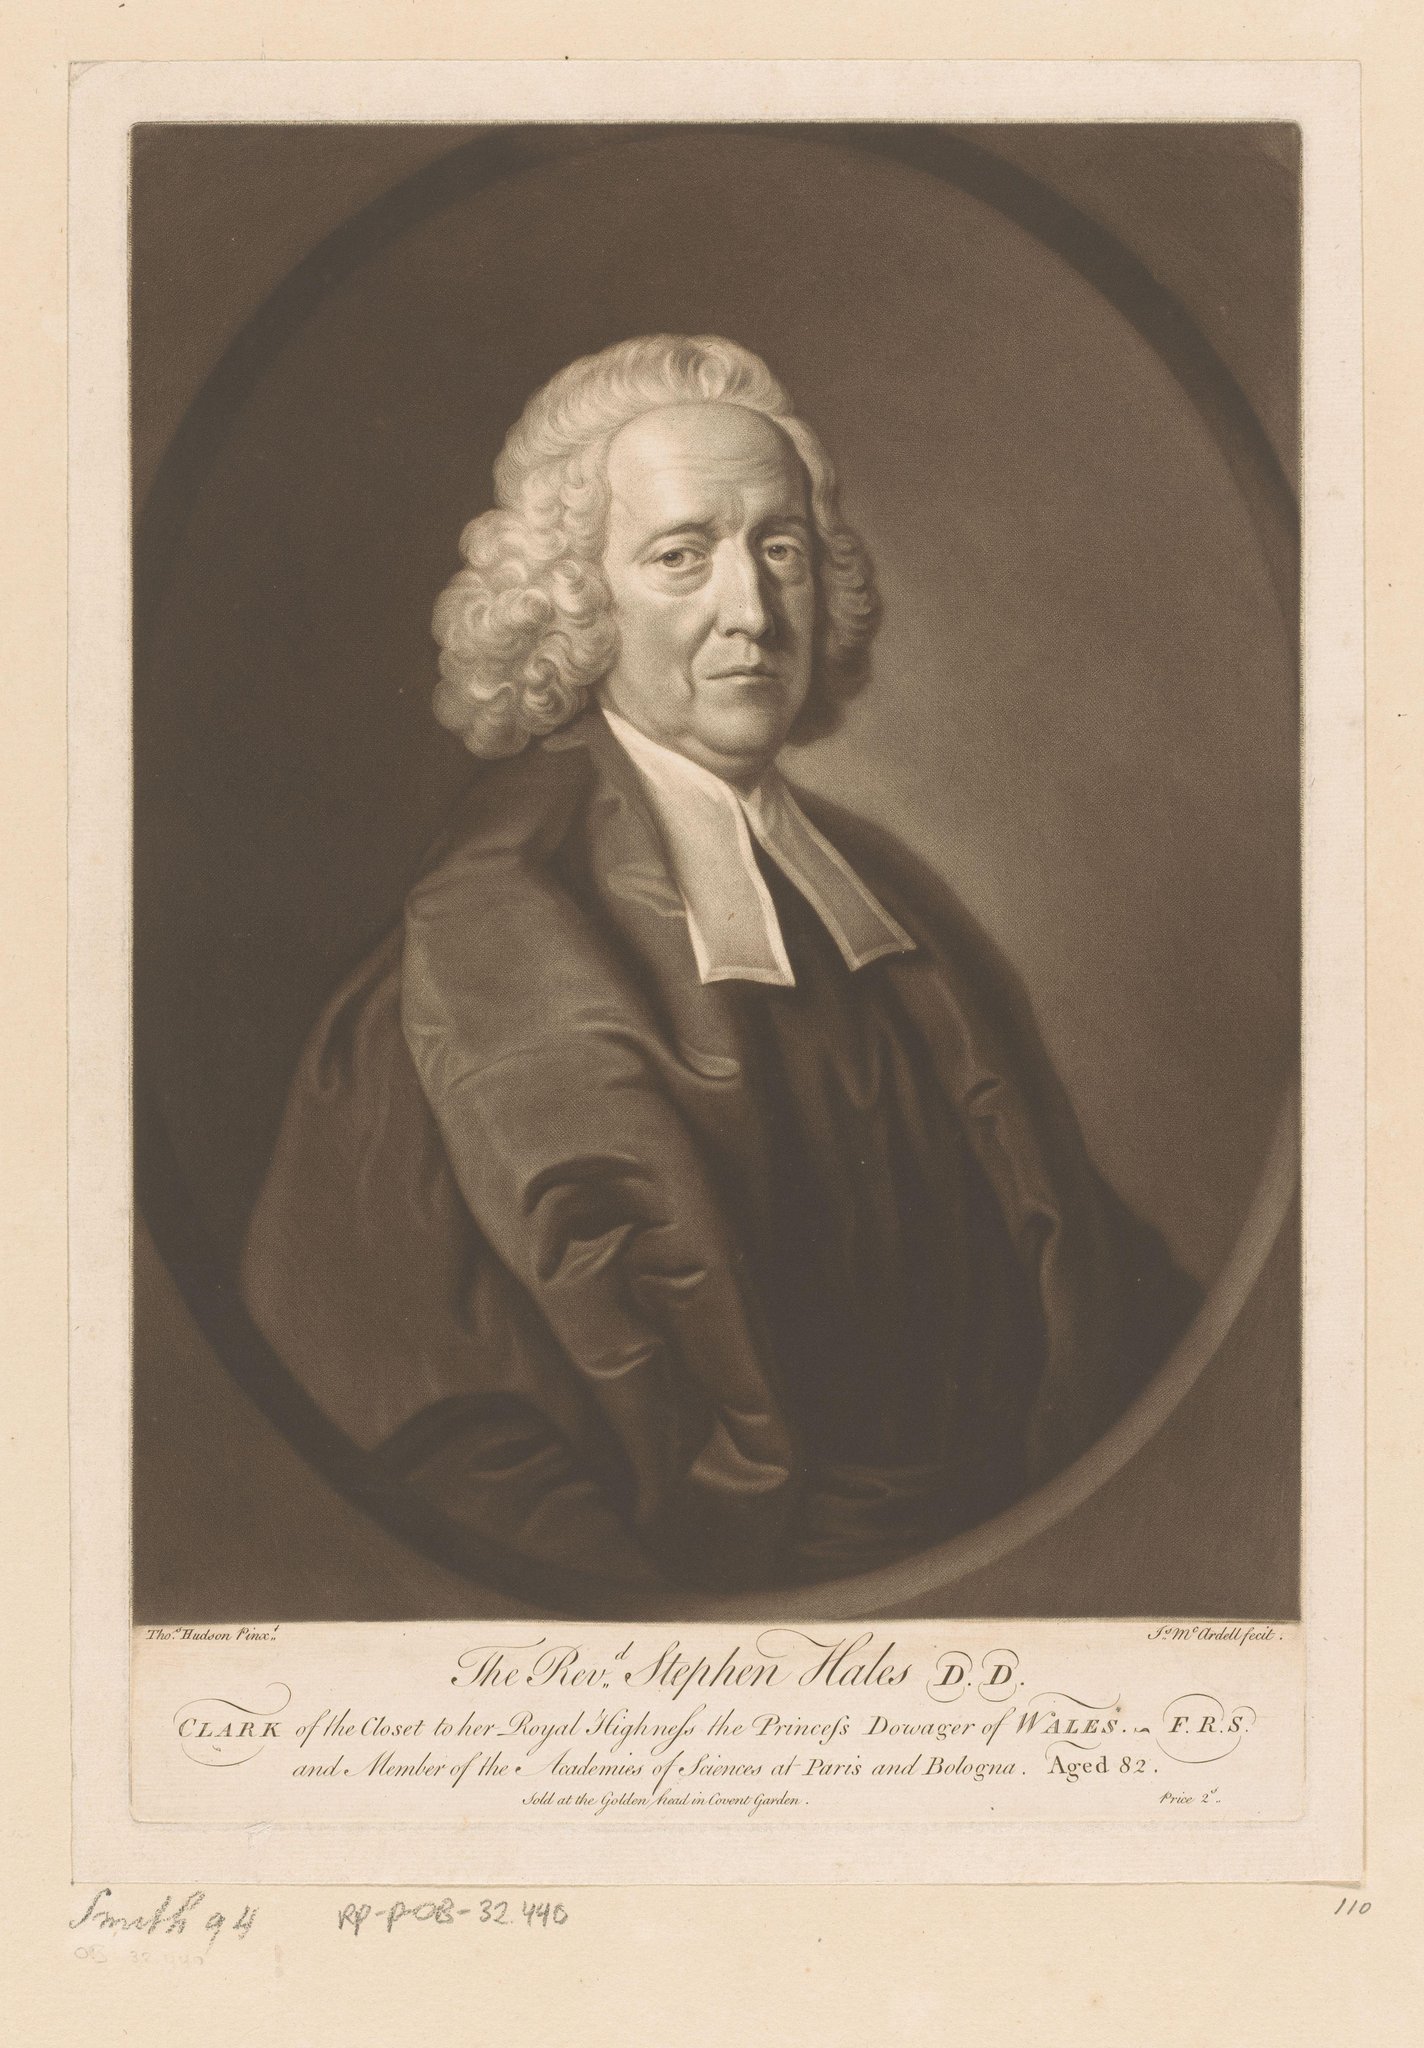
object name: print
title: Portret van Stephen Hales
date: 1760-1761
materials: paper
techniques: mezzotint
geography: london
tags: stephen hales, historical persons, science and technology (+ portrait of scholar, scientist)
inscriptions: collector's mark: Lugt 240